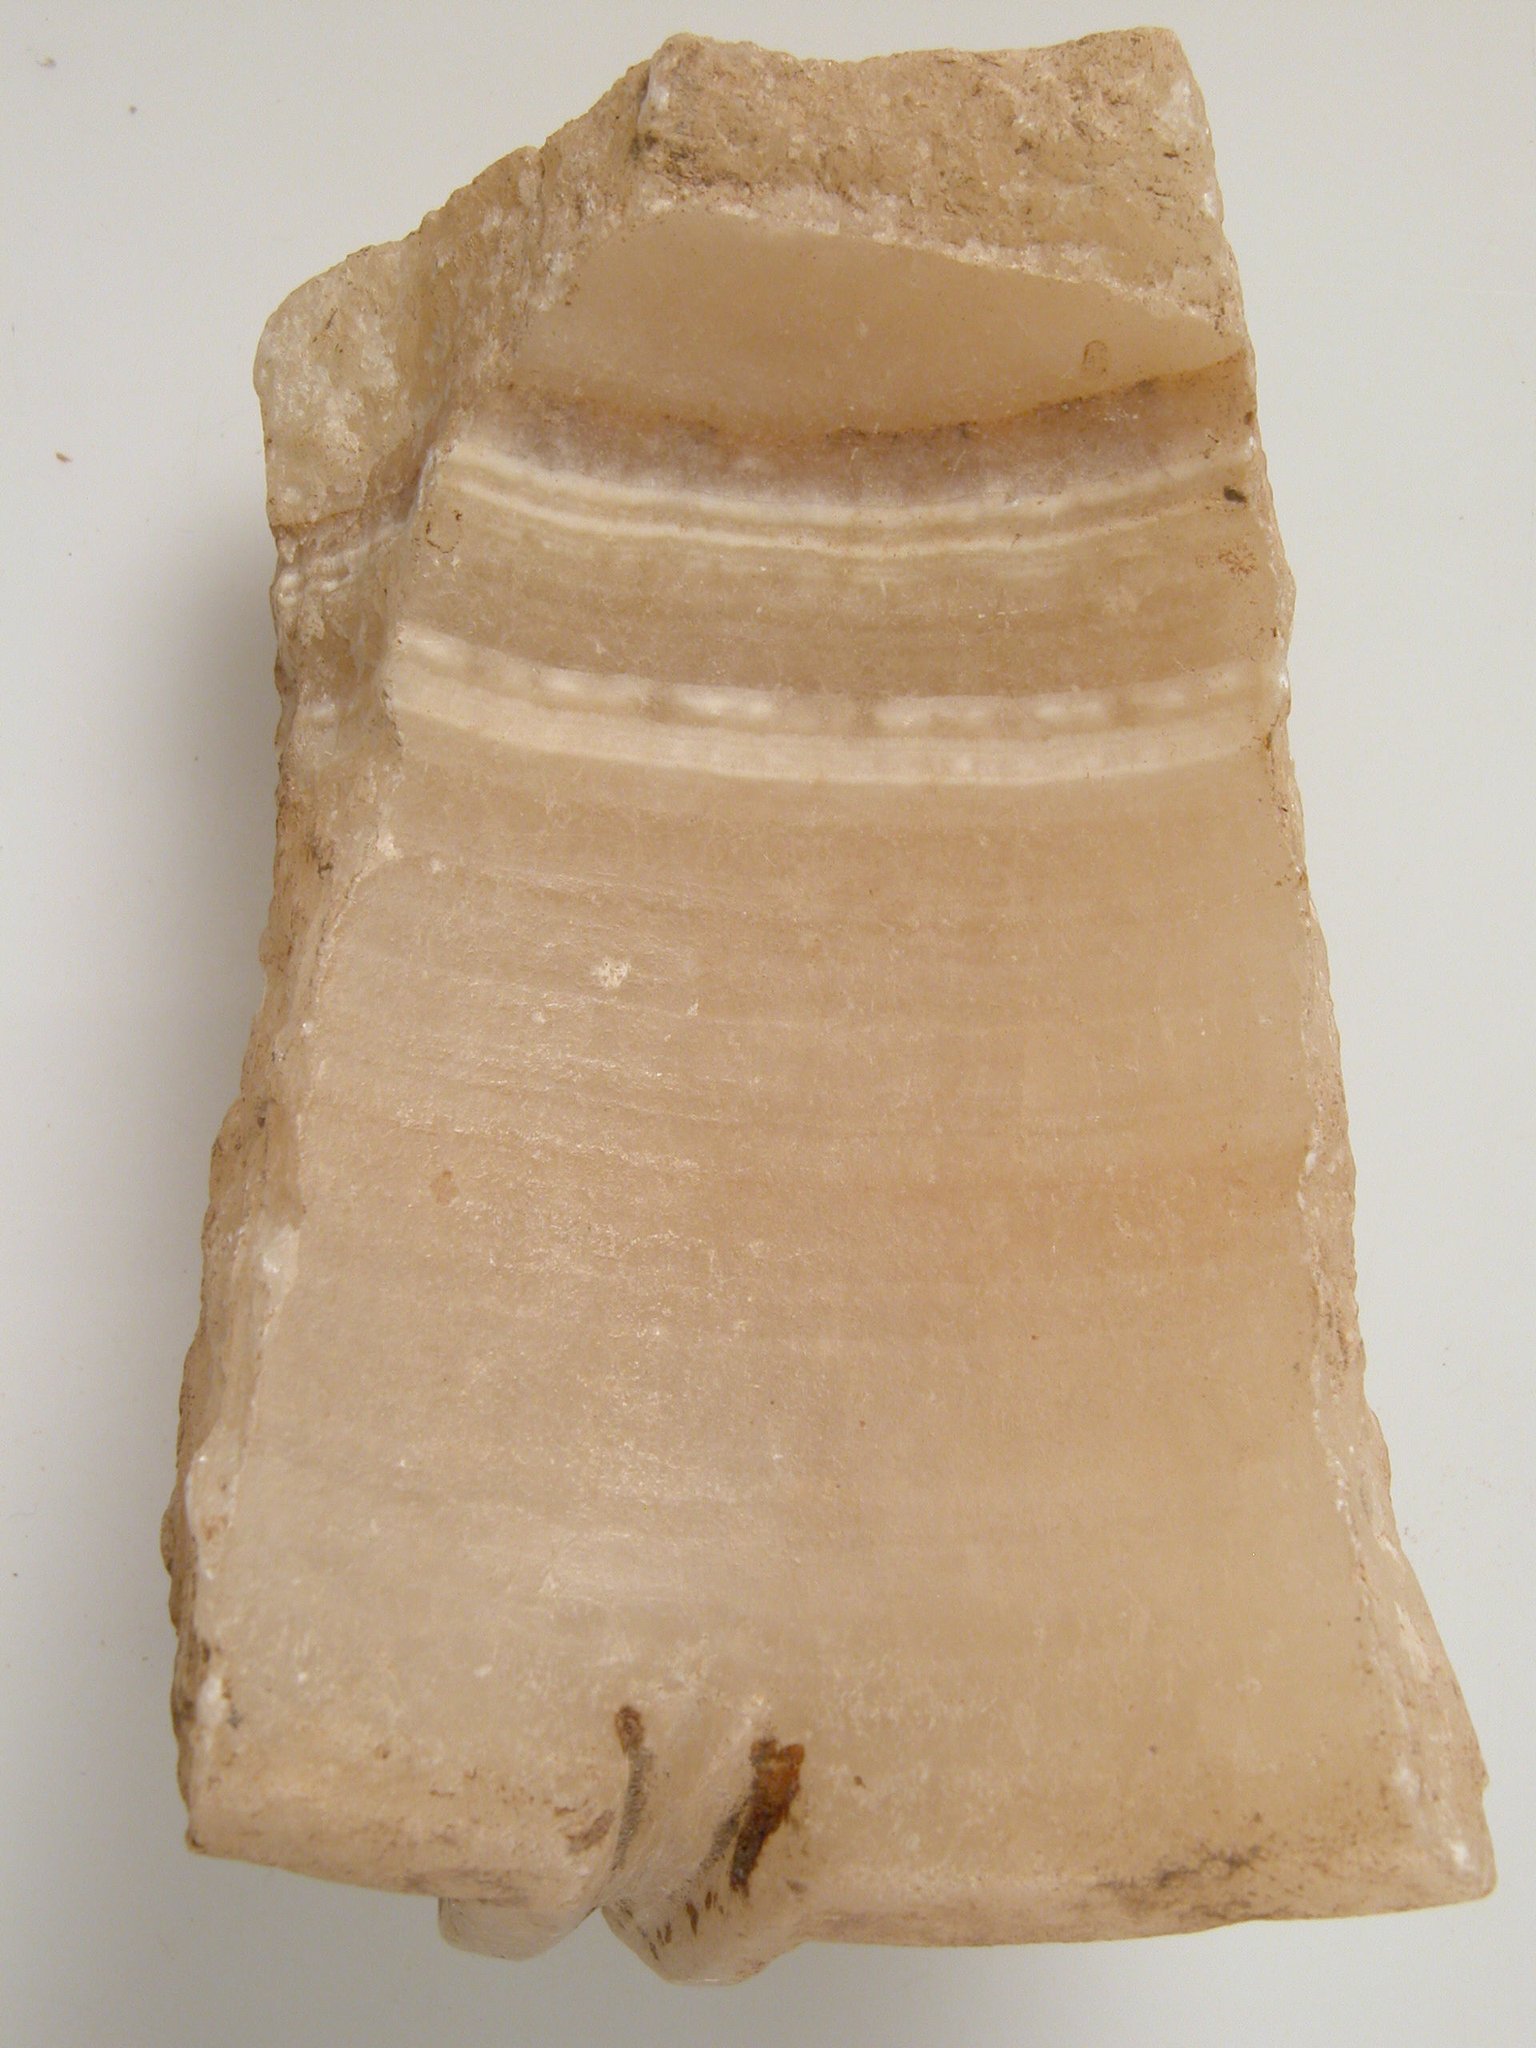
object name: fragment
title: Vessel Fragment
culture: coptic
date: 301-700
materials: alabaster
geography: egypt